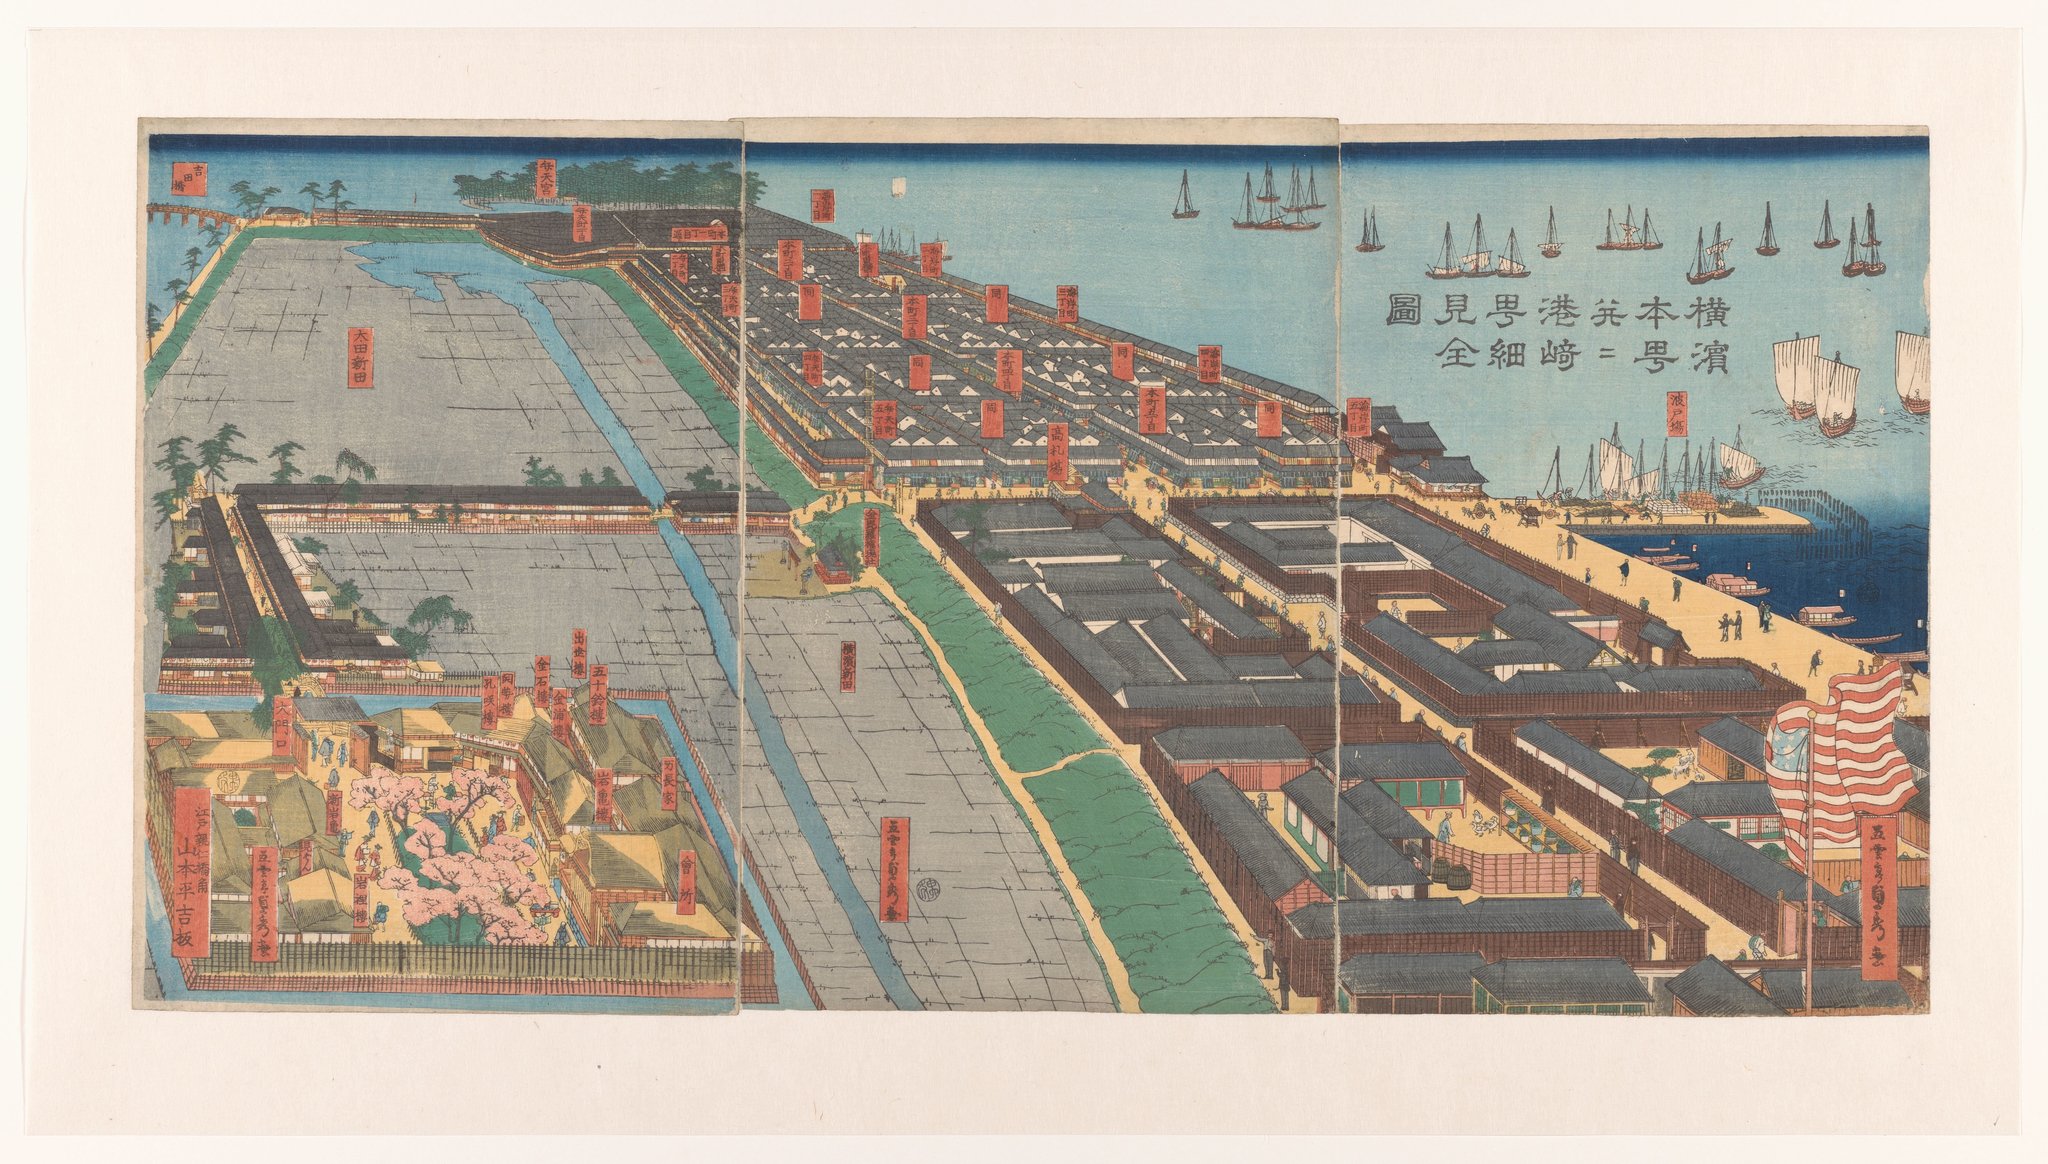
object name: print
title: Yokohama Honcho narabi Miyozakicho saiken zenzu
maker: utagawa sadahide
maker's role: draughtsman, print maker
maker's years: 1807-1873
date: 1804-1860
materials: paper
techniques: woodcut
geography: japan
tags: prospect of city, town panorama, silhouette of city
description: Een gezicht in vogelvlucht op Yokohama. De rode labels geven de namen van de verschillende locaties aan. Links onder ligt de uitgaanswijk Miyozaki, hier woonden en werkten de courtisanes. De buitenlanders woonden in de wijk rechts onder, nabij de haven. De Japanners zelf woonden in het gebied rechts boven. (Yokohama-e triptiek).